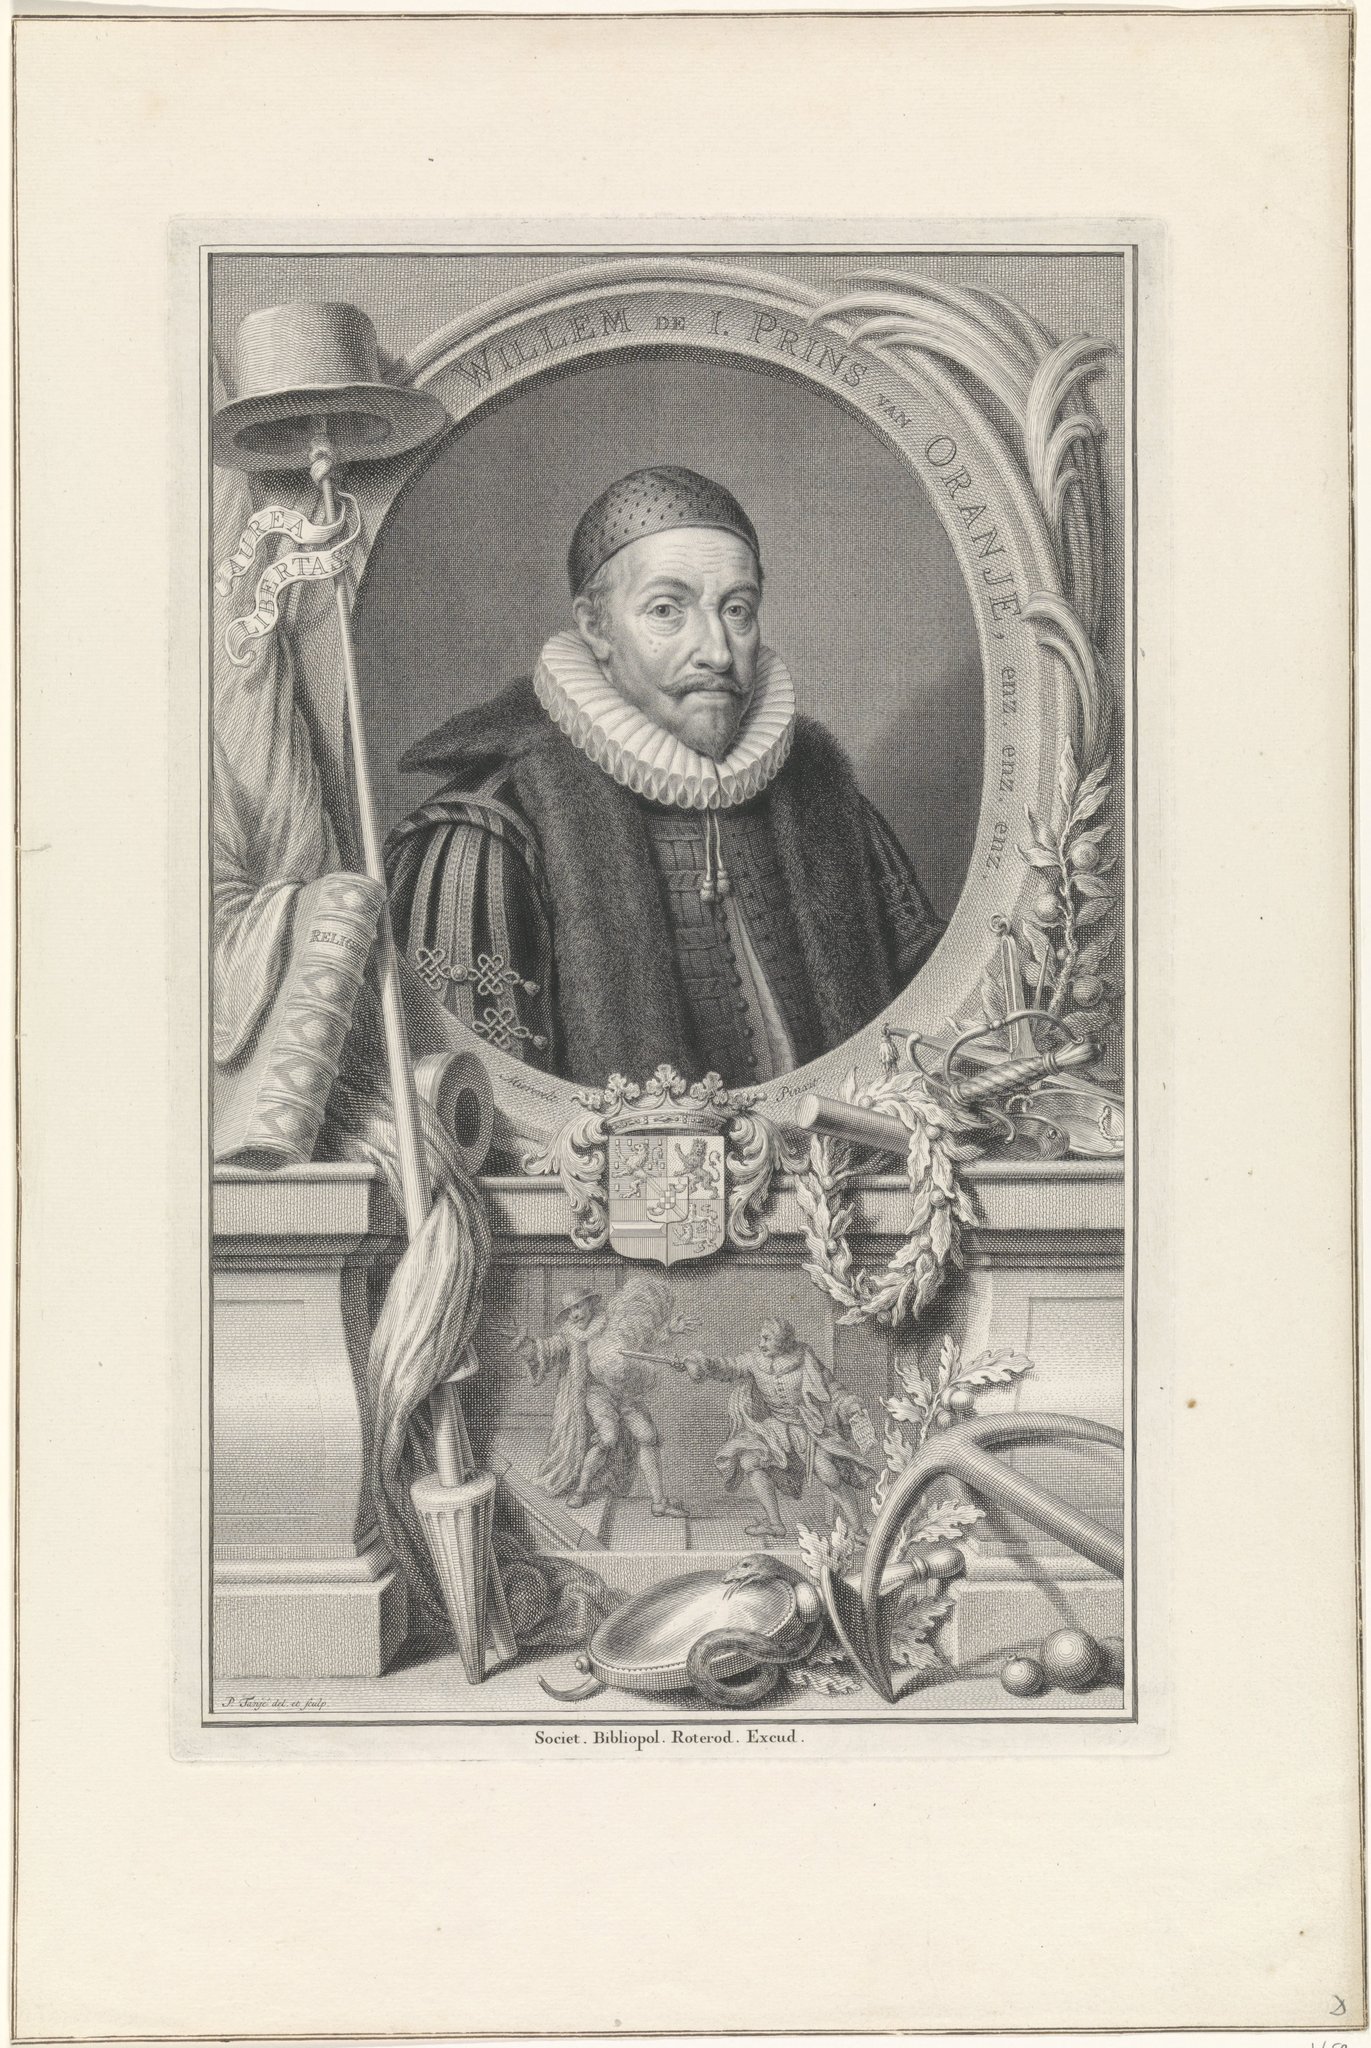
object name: print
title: Portret van Willem I, prins van Oranje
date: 1748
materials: paper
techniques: engraving, etching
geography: amsterdam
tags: delft, william i (prince of orange), prudence, 'prudentia'; 'prudenza' (ripa) ~ one of the four cardinal virtues, murder, freedom, liberty; 'libertà' (ripa), parts of ship's exterior: anchor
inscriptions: collector's mark: Lugt 2228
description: Portret van Willem I in een ovaal met randschrift en in het midden zijn wapen. Rondom liggen een aantal allegorische objecten, waaronder een palm en oranjetakken, een degen, een weegschaal, een vrijheidslans met een vrijheidshoed, een boek, een spiegel en een slang als symbool van Voorzichtigheid, het anker van de hoop en een lauwerkrans. Op het reliëf een voorstelling van de moord op Willem I door Balthasar Gerards op de trap van het Prinsenhof te Delft.